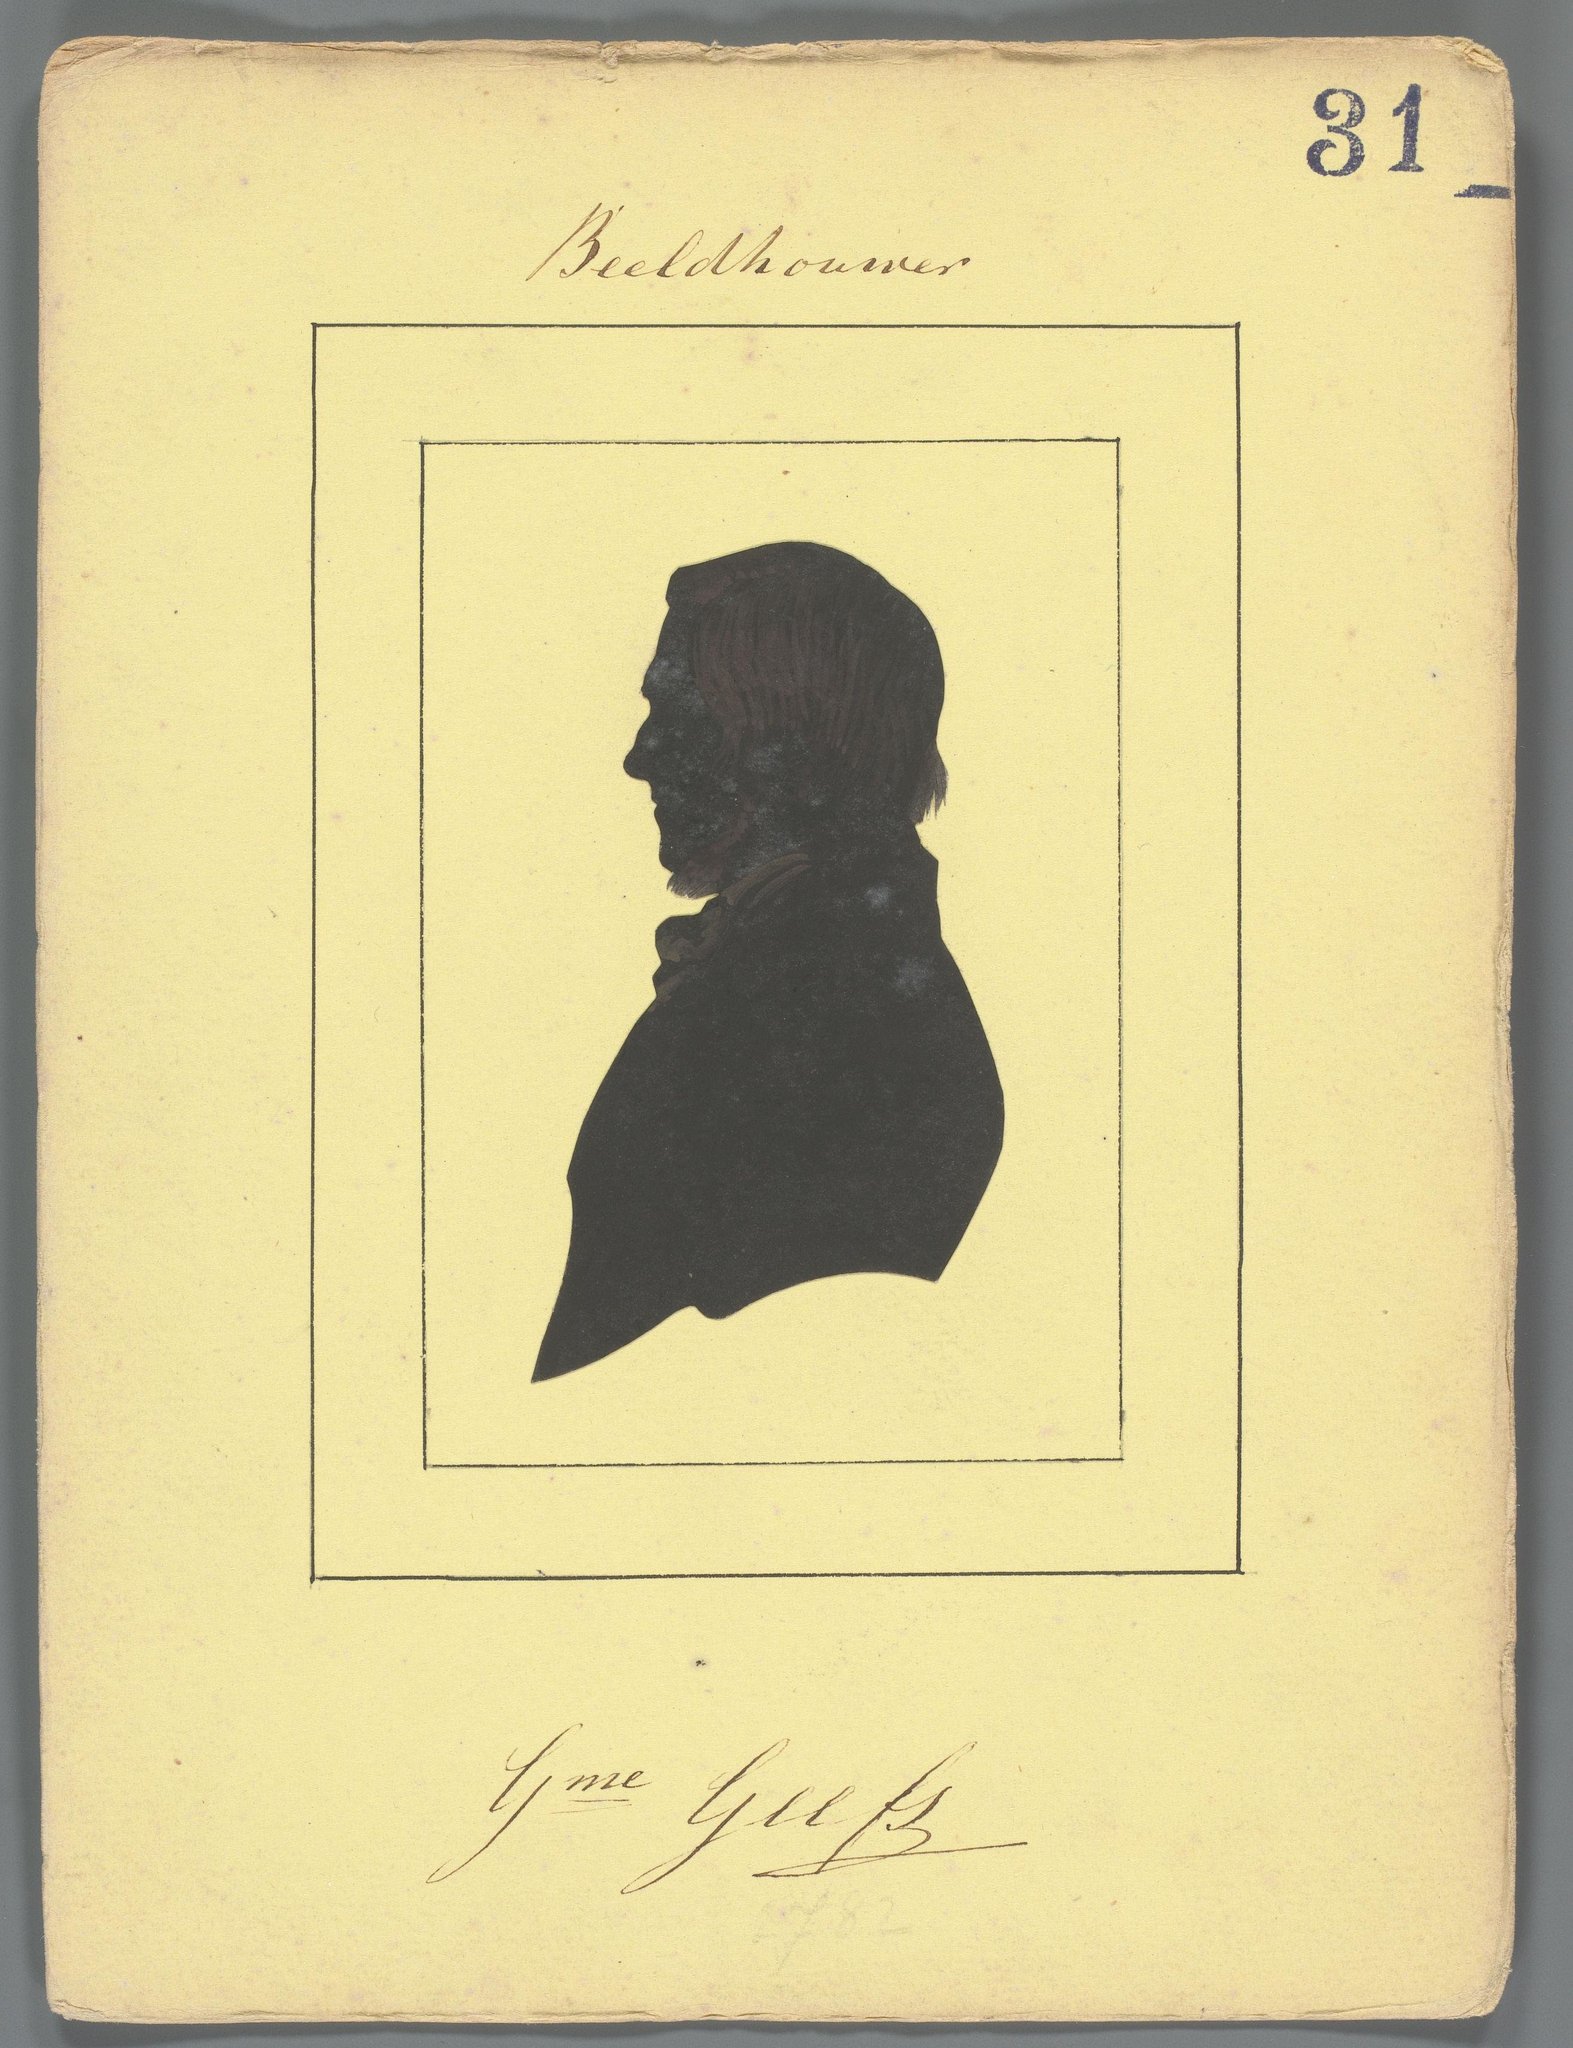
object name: drawing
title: Silhouetportret van Willem Geefs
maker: elisabeth alida haanen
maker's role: draughtsman, print maker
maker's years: 1809-1845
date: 1819-1845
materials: ink, paint, paper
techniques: brush, snipping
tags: antwerp, sculptor, willem geefs, portrait, self-portrait of sculptor, historical persons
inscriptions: number: ‘31’, inscription: ‘Neg. D. 1771’, inscription: ‘Beeldhouwer’, number: ‘13931’, inscription: ‘Gme Geefs’, collector's mark: ‘Ex-libris van Beresteyn’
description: Met onder het portret de handtekening van de geportretteerde.